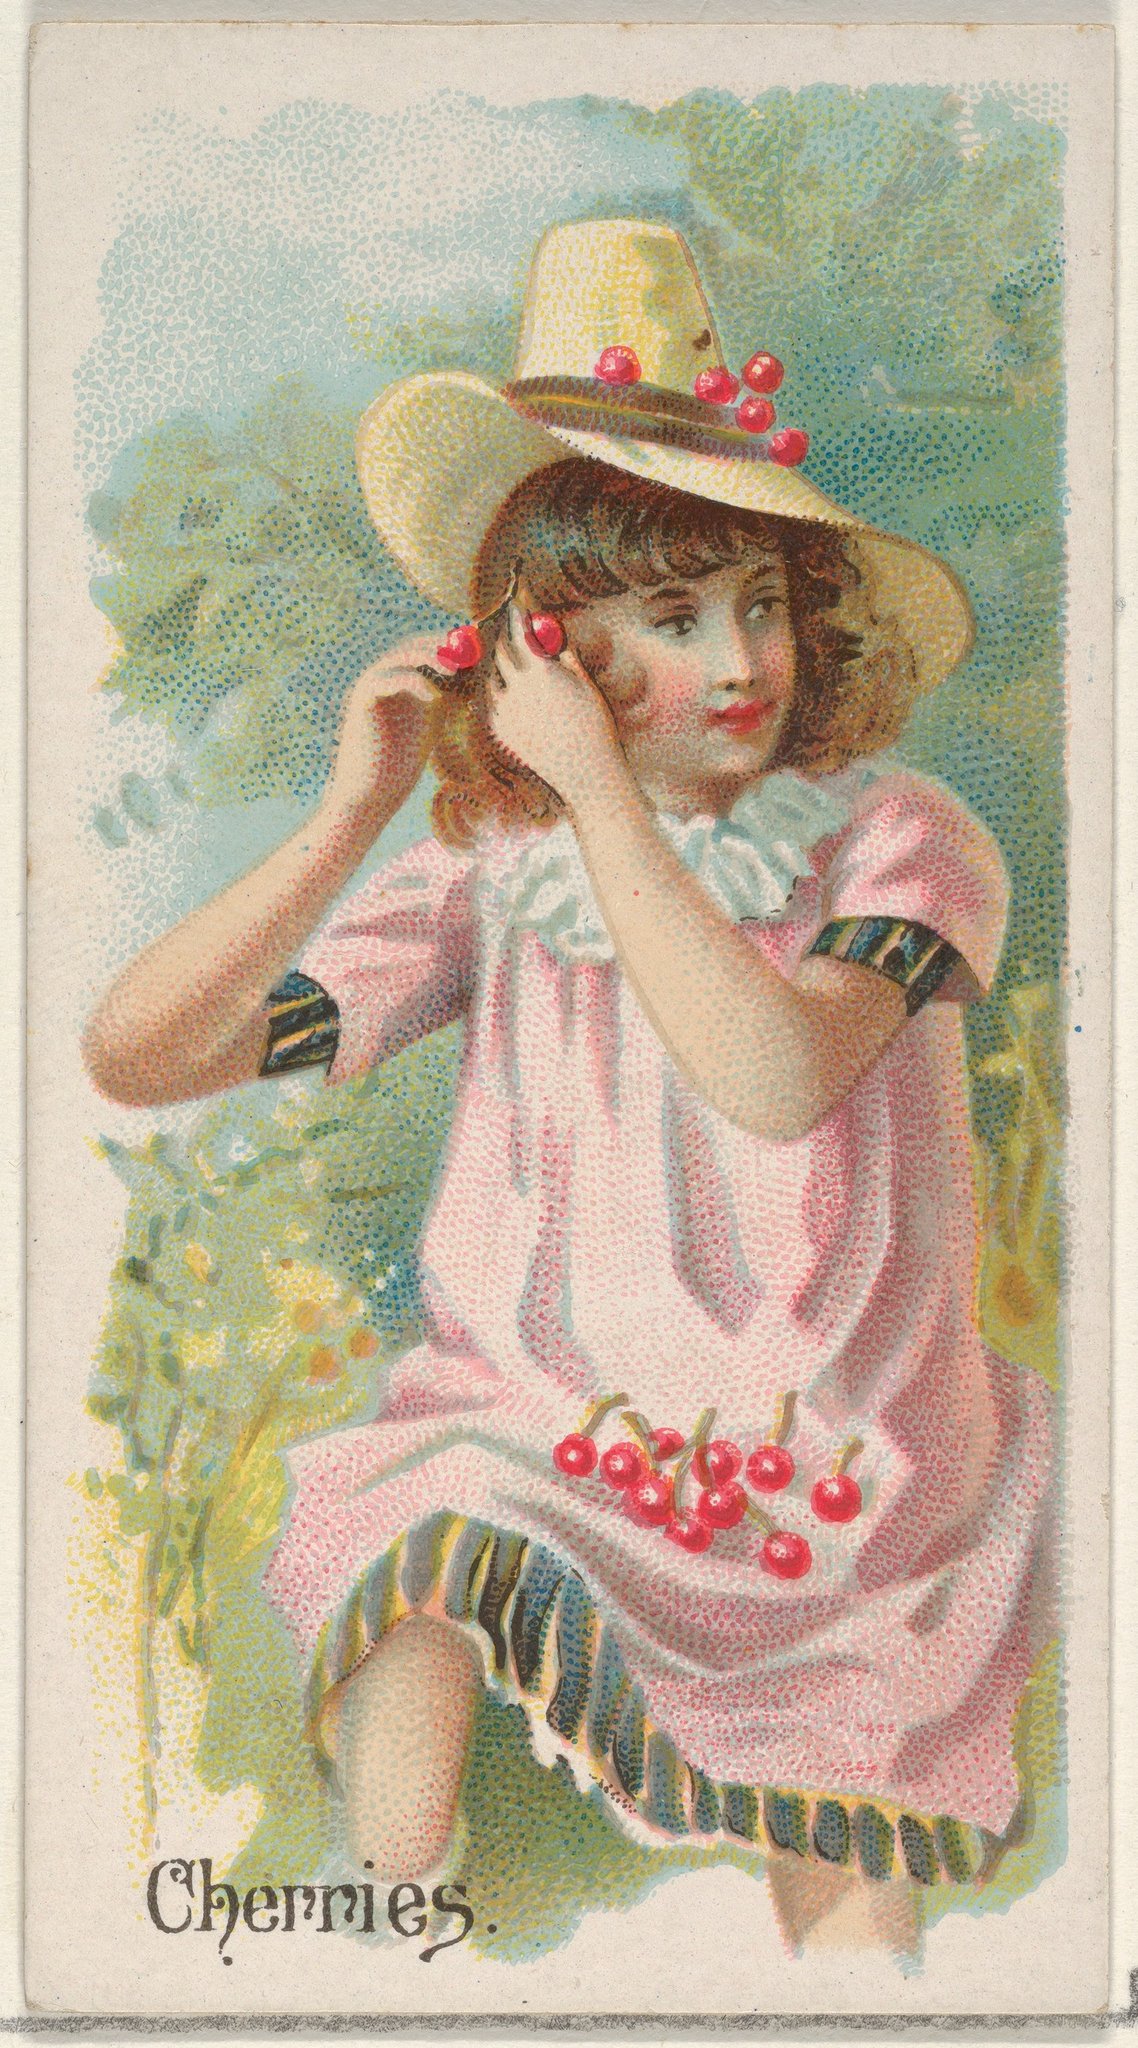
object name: print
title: Cherries, from the Fruits series (N12) for Allen & Ginter Cigarettes Brands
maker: allen & ginter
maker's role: publisher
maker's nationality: american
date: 1891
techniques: color lithograph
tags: cherries,girls